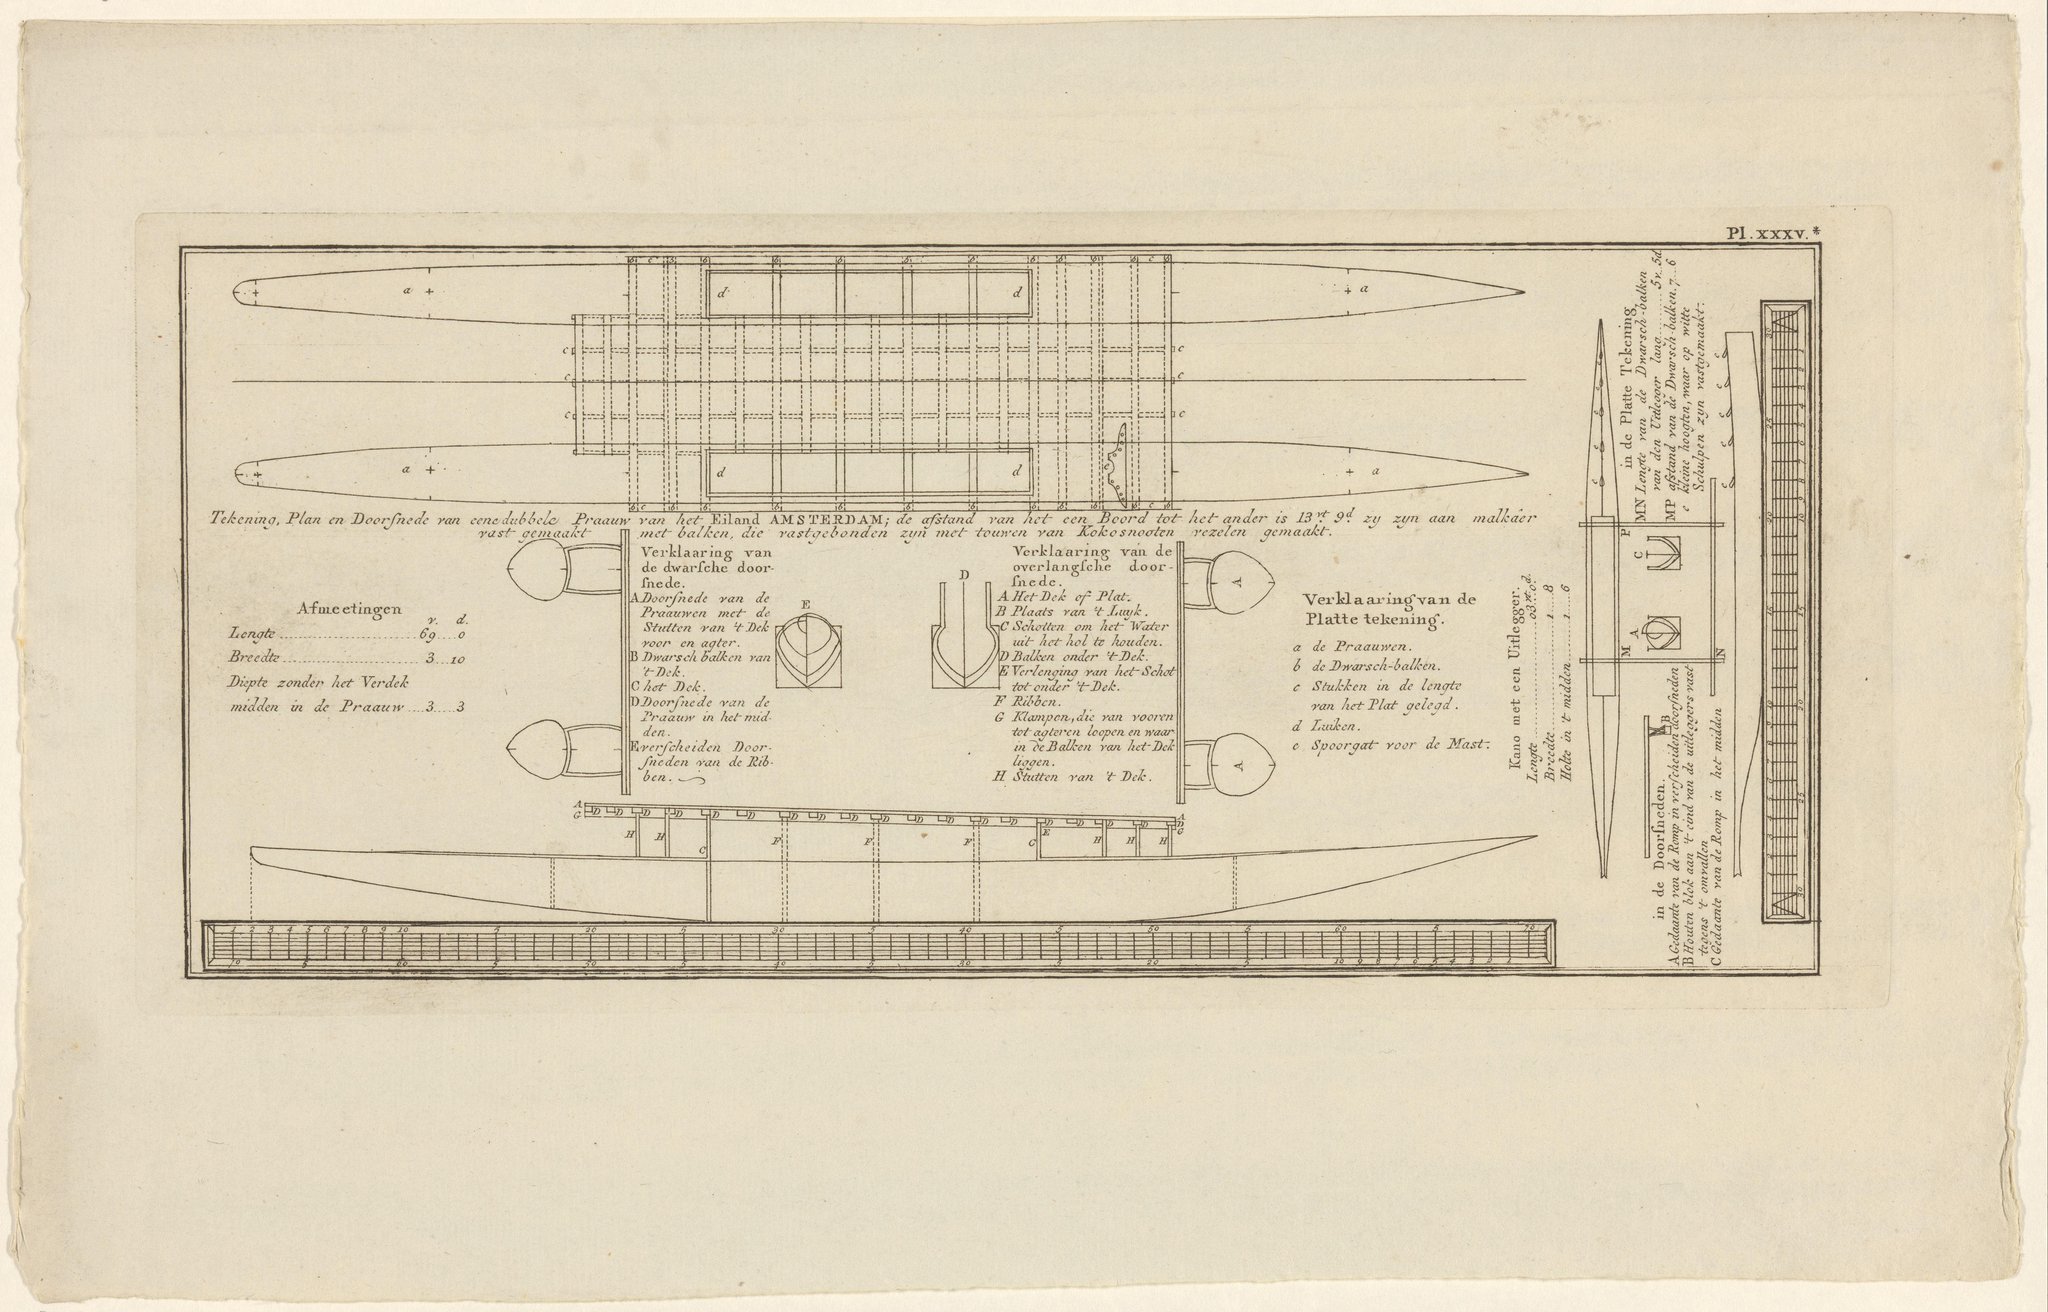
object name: print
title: Dwarsdoorsnede van een prauw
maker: Anonymous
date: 1750-1850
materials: paper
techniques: etching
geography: netherlands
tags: rowing-boat, canoe, etc., section ~ architectural design or model, boat propelled by man or animal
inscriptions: collector's mark: Lugt 2228, watermark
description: Mogelijk een prent uit een Nederlandse editie van de reizen van James Cook.